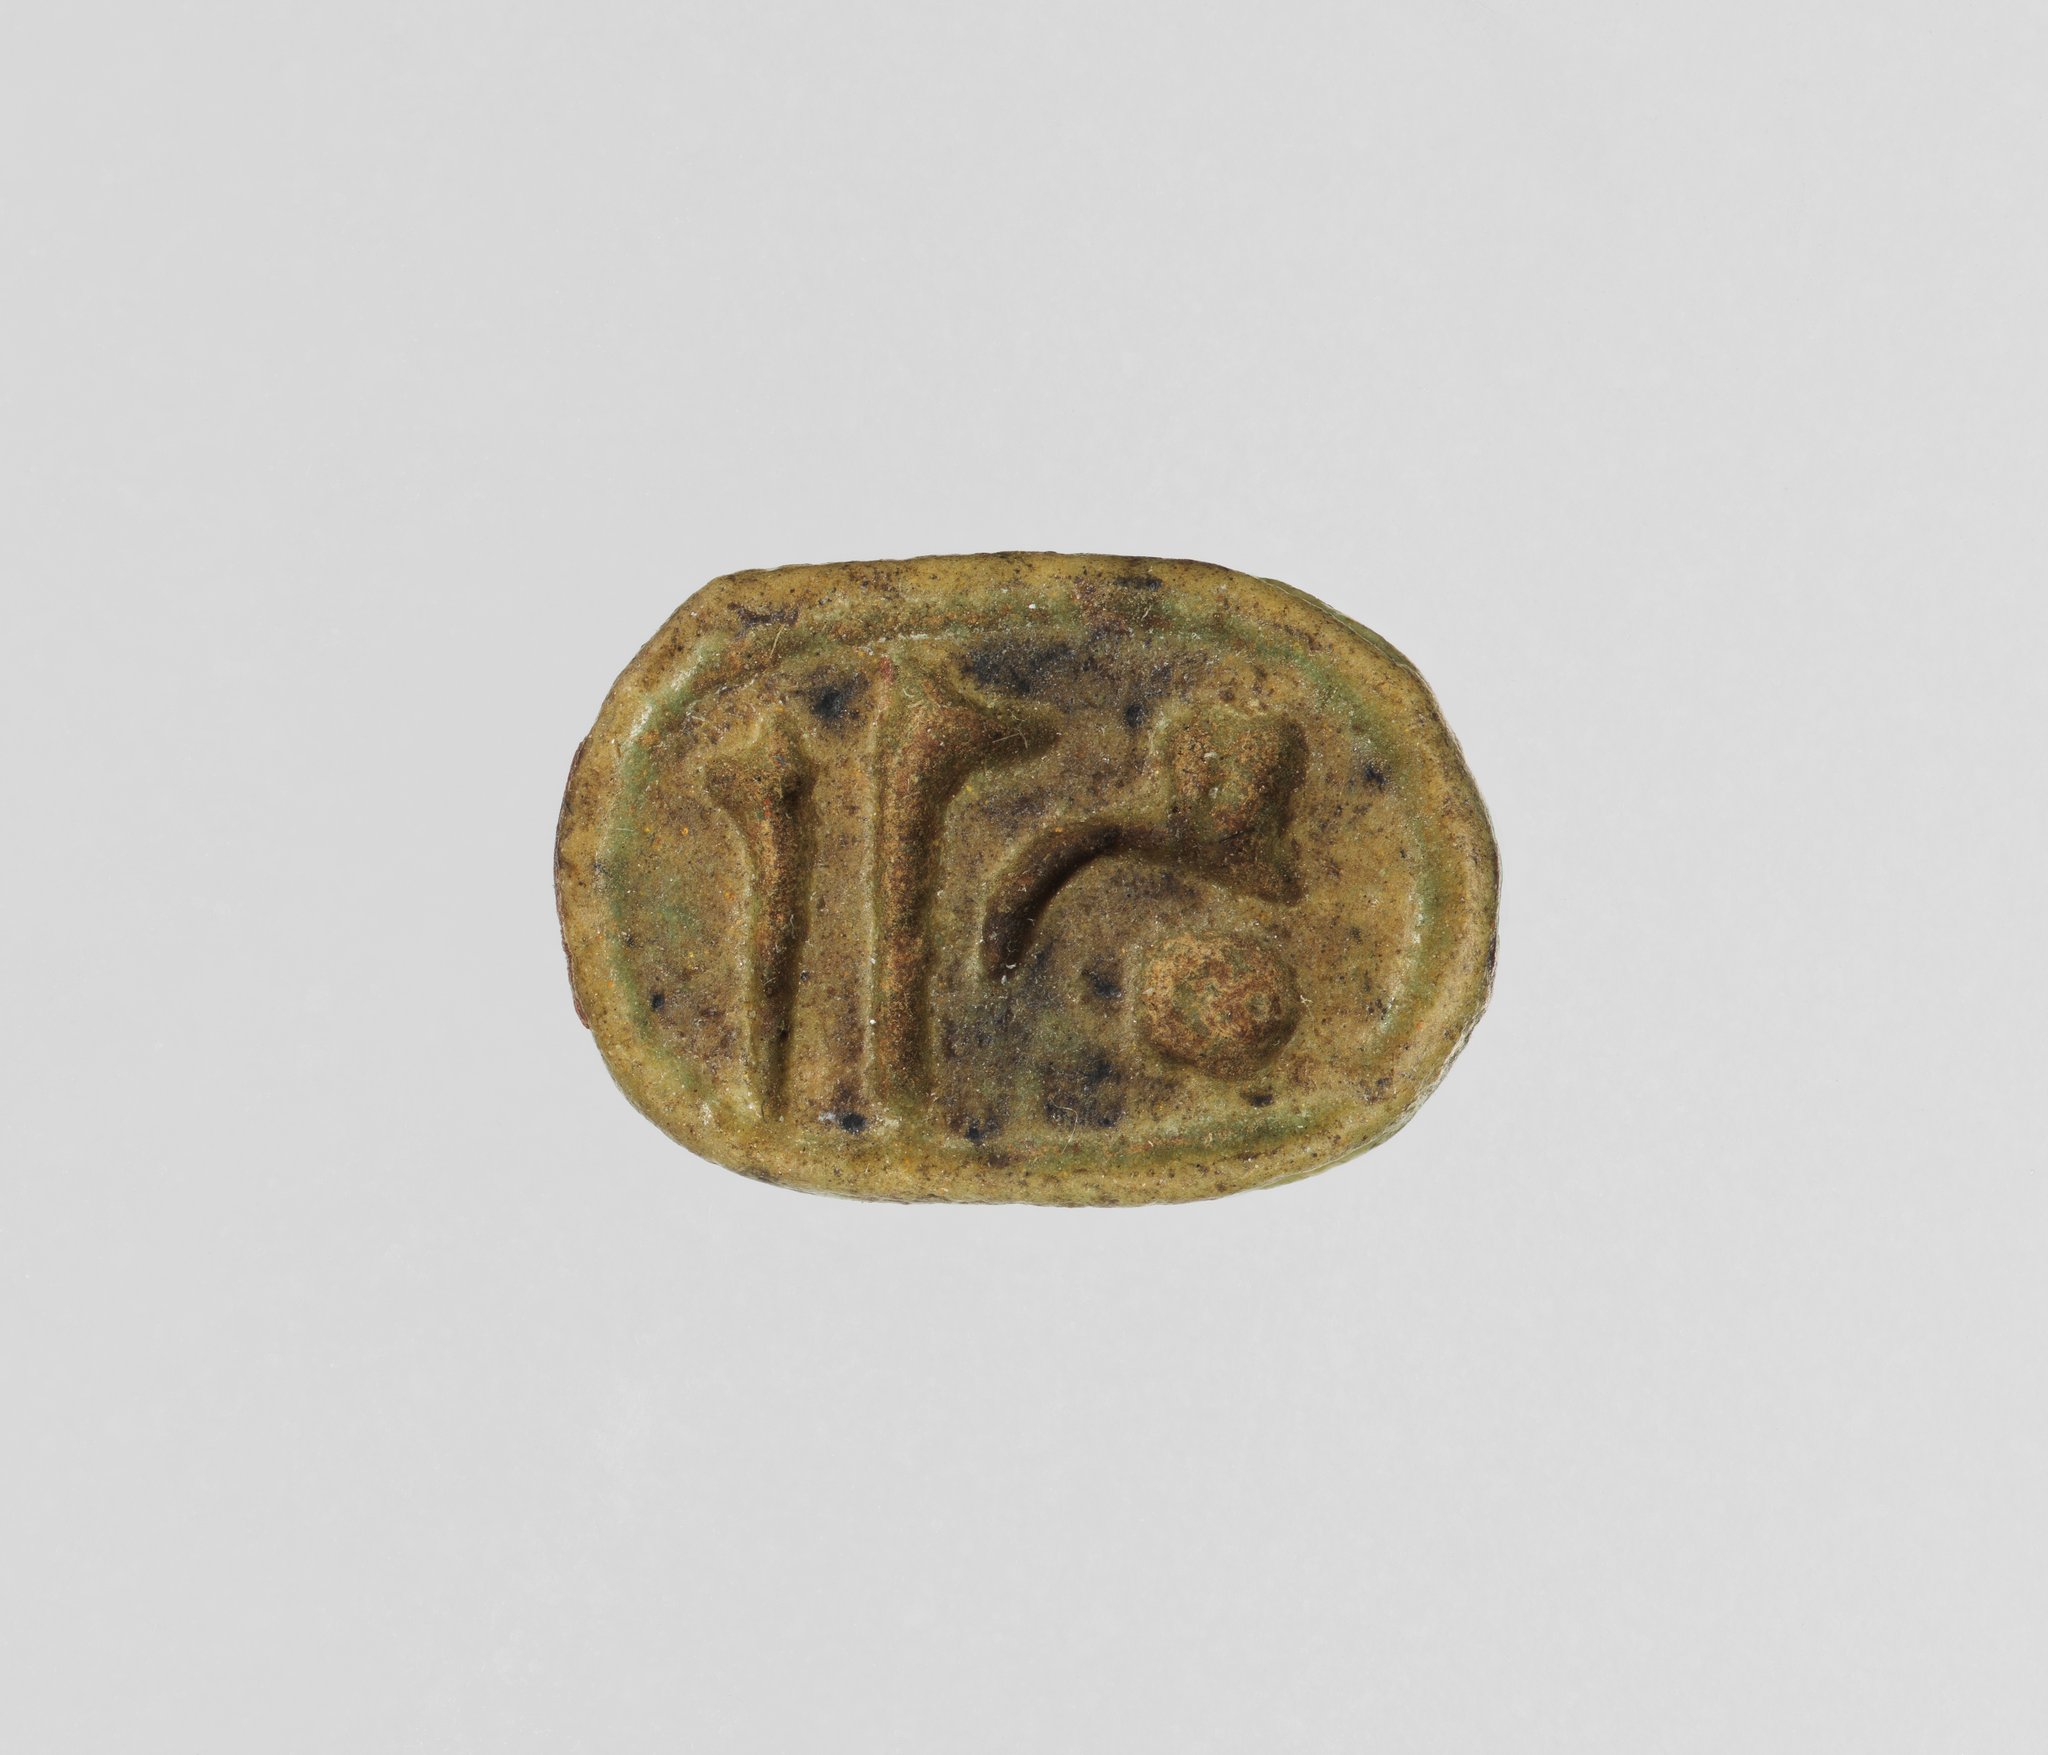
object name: scarab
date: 1295-1070 BCE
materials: faience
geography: egypt